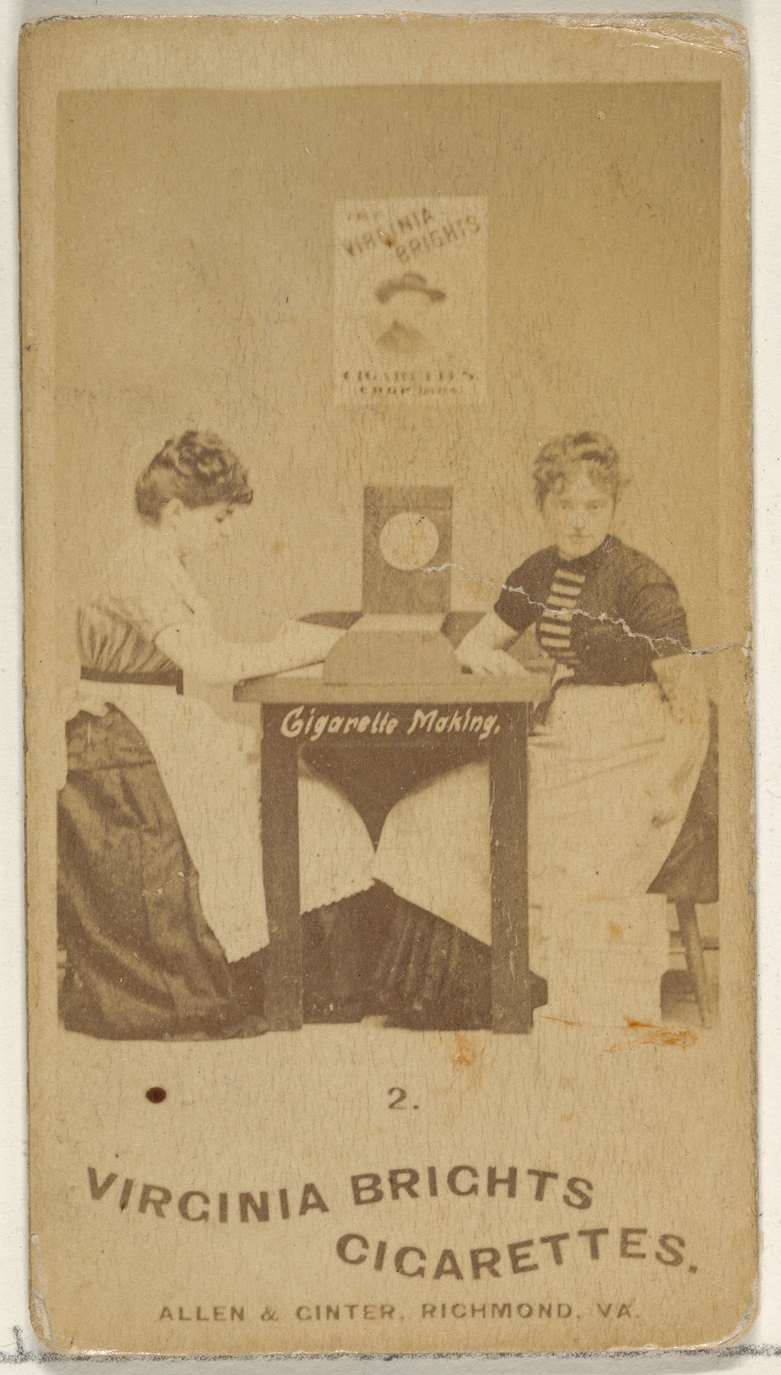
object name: photograph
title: Card 2, from the series, Cigarette Making Girls (N46) for Virginia Brights Cigarettes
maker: allen & ginter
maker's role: publisher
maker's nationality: american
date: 1888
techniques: albumen silver print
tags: portraits,women